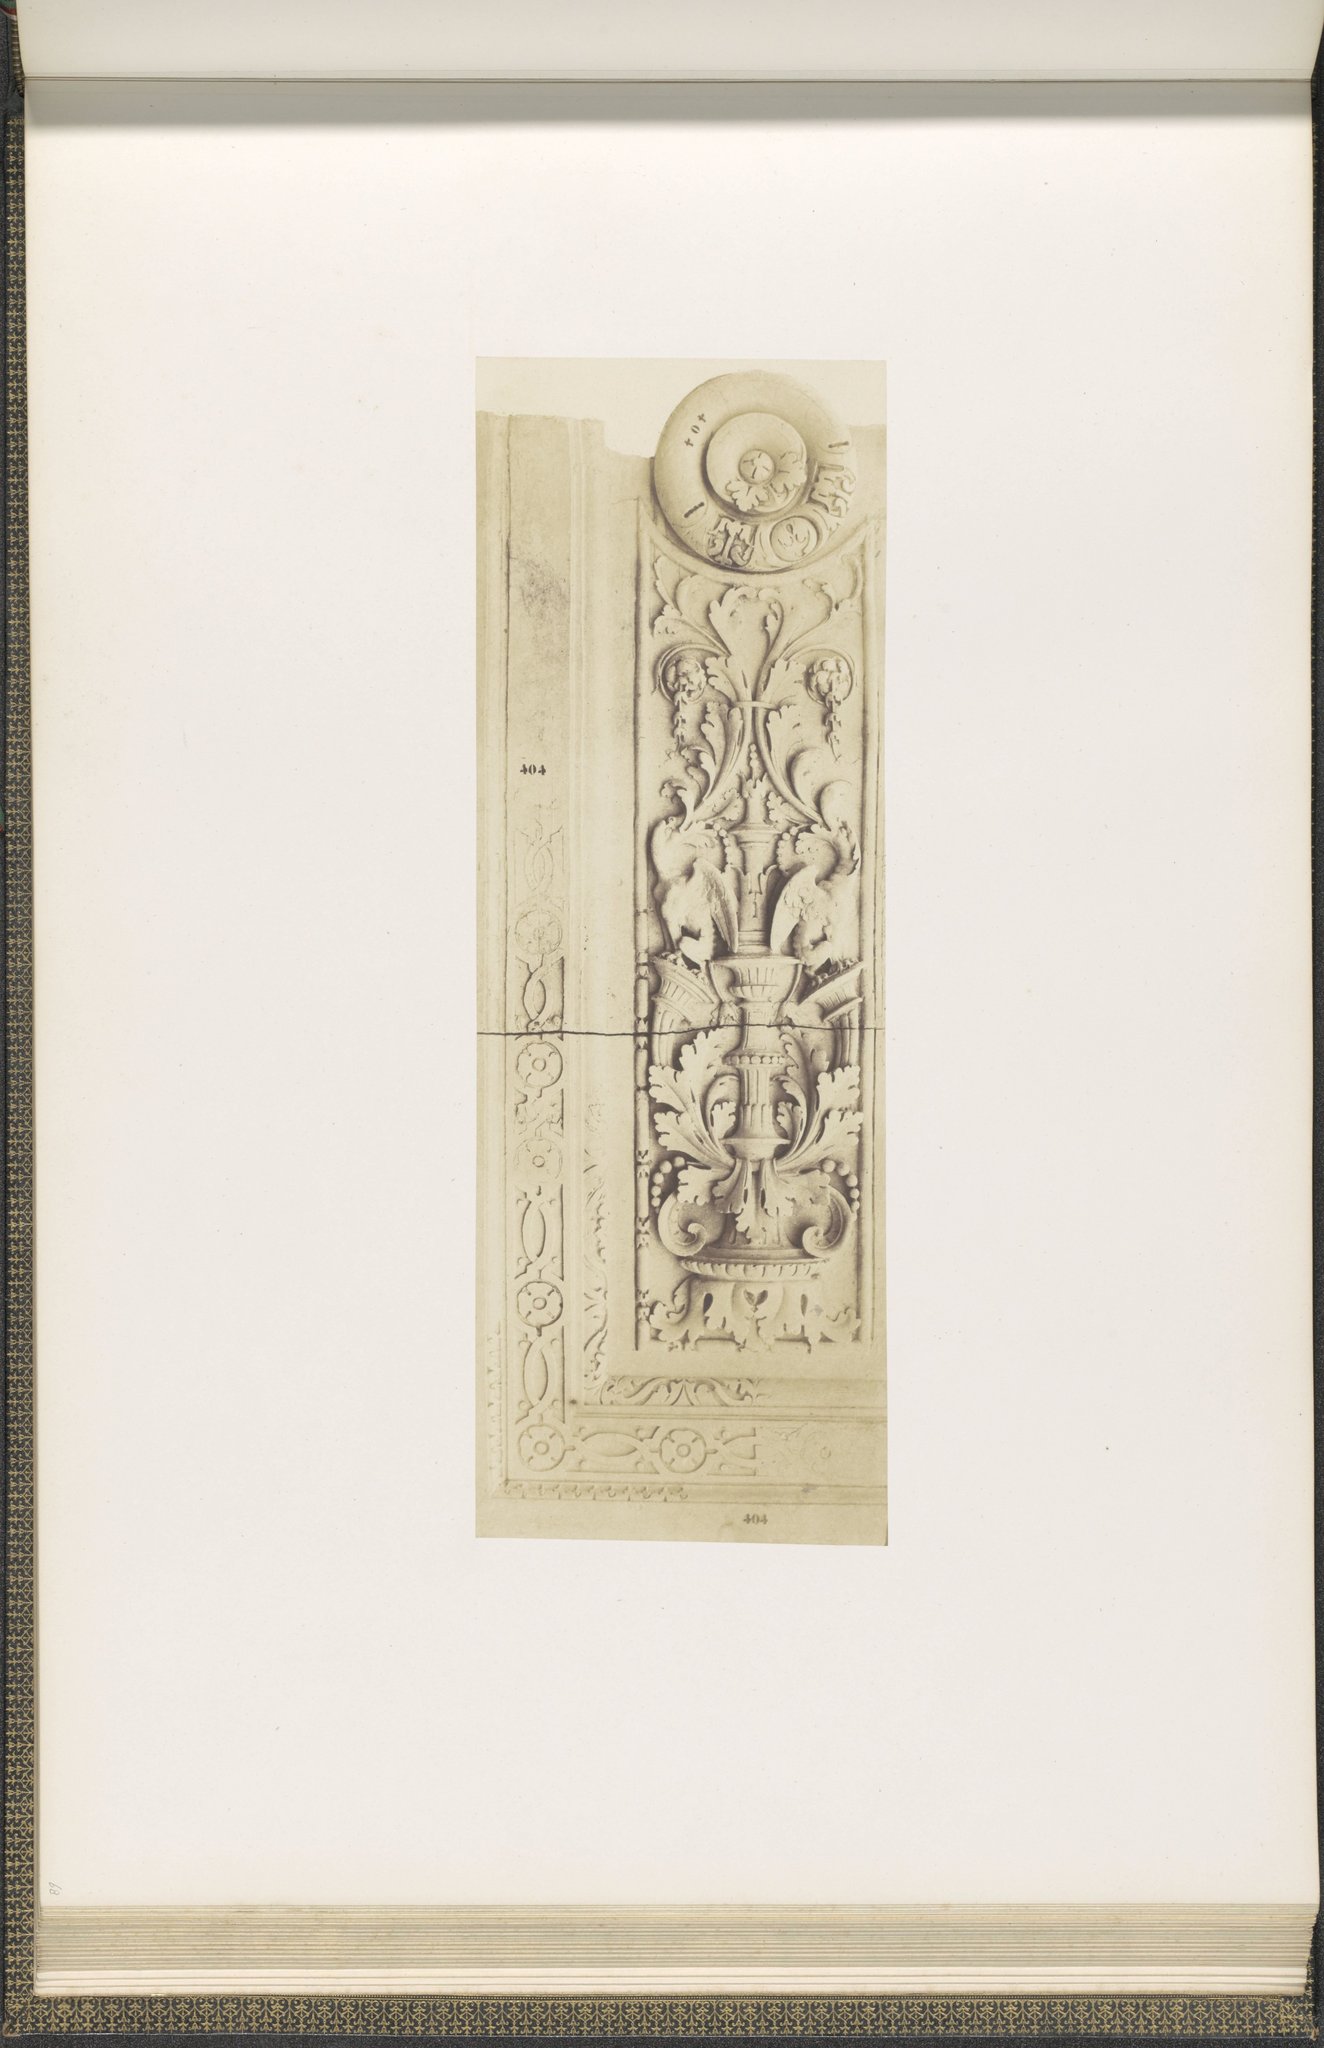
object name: photograph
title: Gipsmodel voor een versiering van het Pavillon Richelieu in het Palais du Louvre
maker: édouard denis baldus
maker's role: fotograaf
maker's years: 1813-1889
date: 1855-1857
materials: paper, photographic support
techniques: salted paper print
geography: paris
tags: permanent exhibition, museum, ornamenting, decorating ~ applied arts, paris, tuileries palace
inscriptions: number: ‘404’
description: Onderdeel van Réunion des Tuileries au Louvre 1852-1857, album 4.